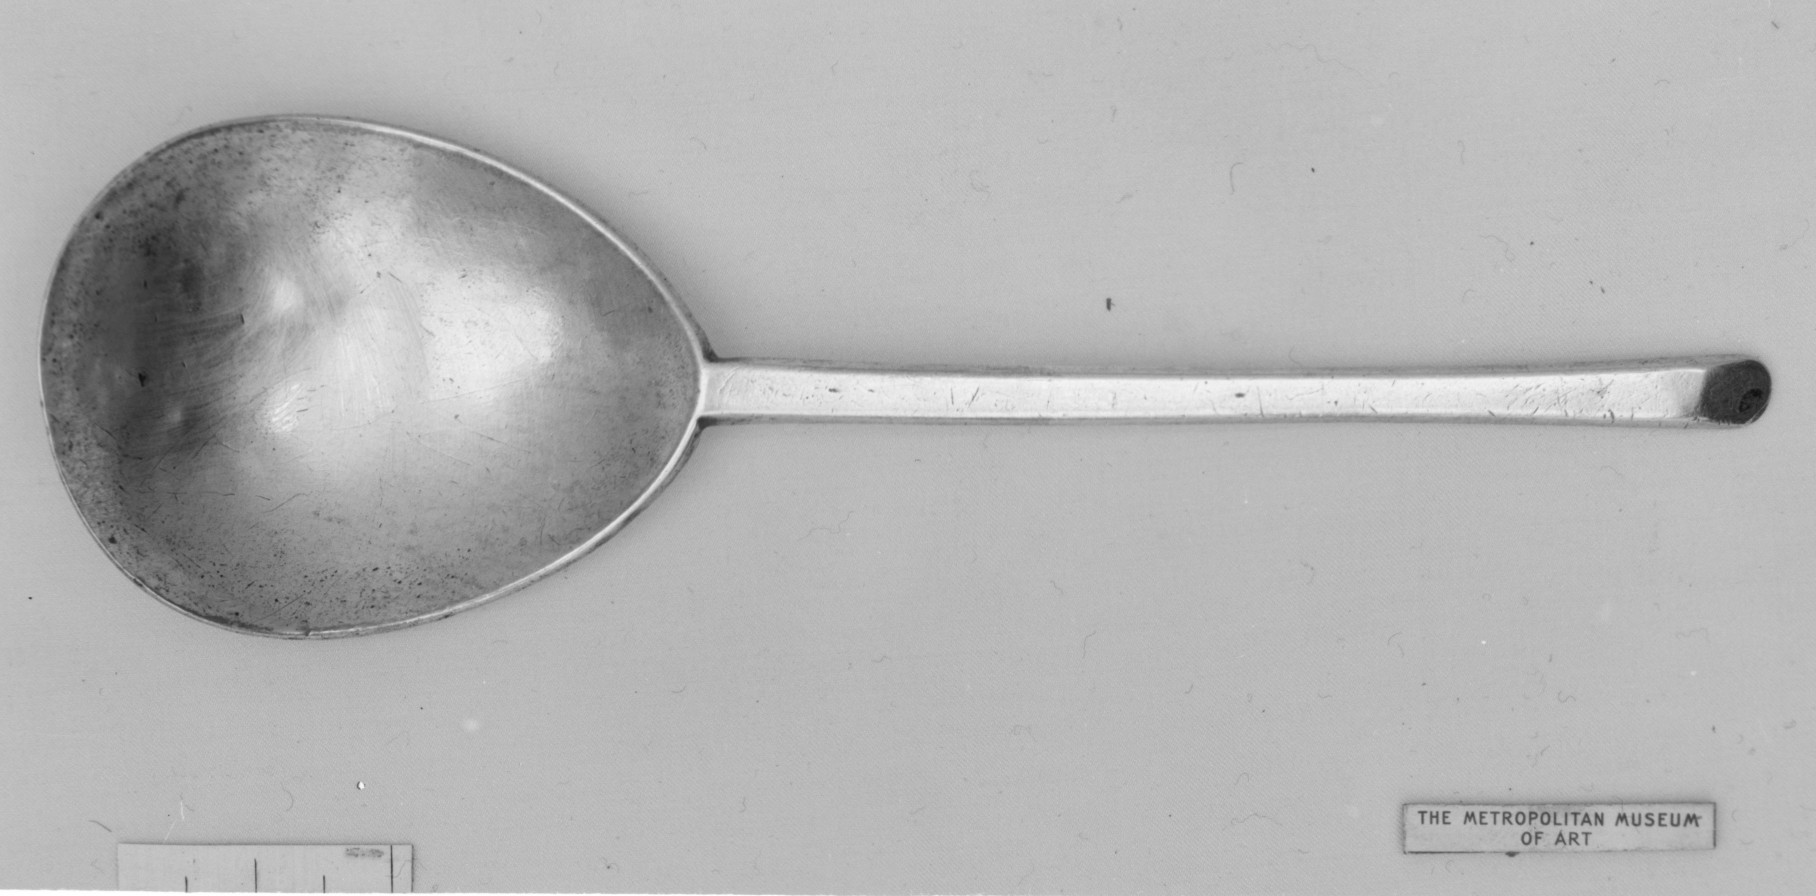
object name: apostle spoon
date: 1801-1900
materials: silver gilt